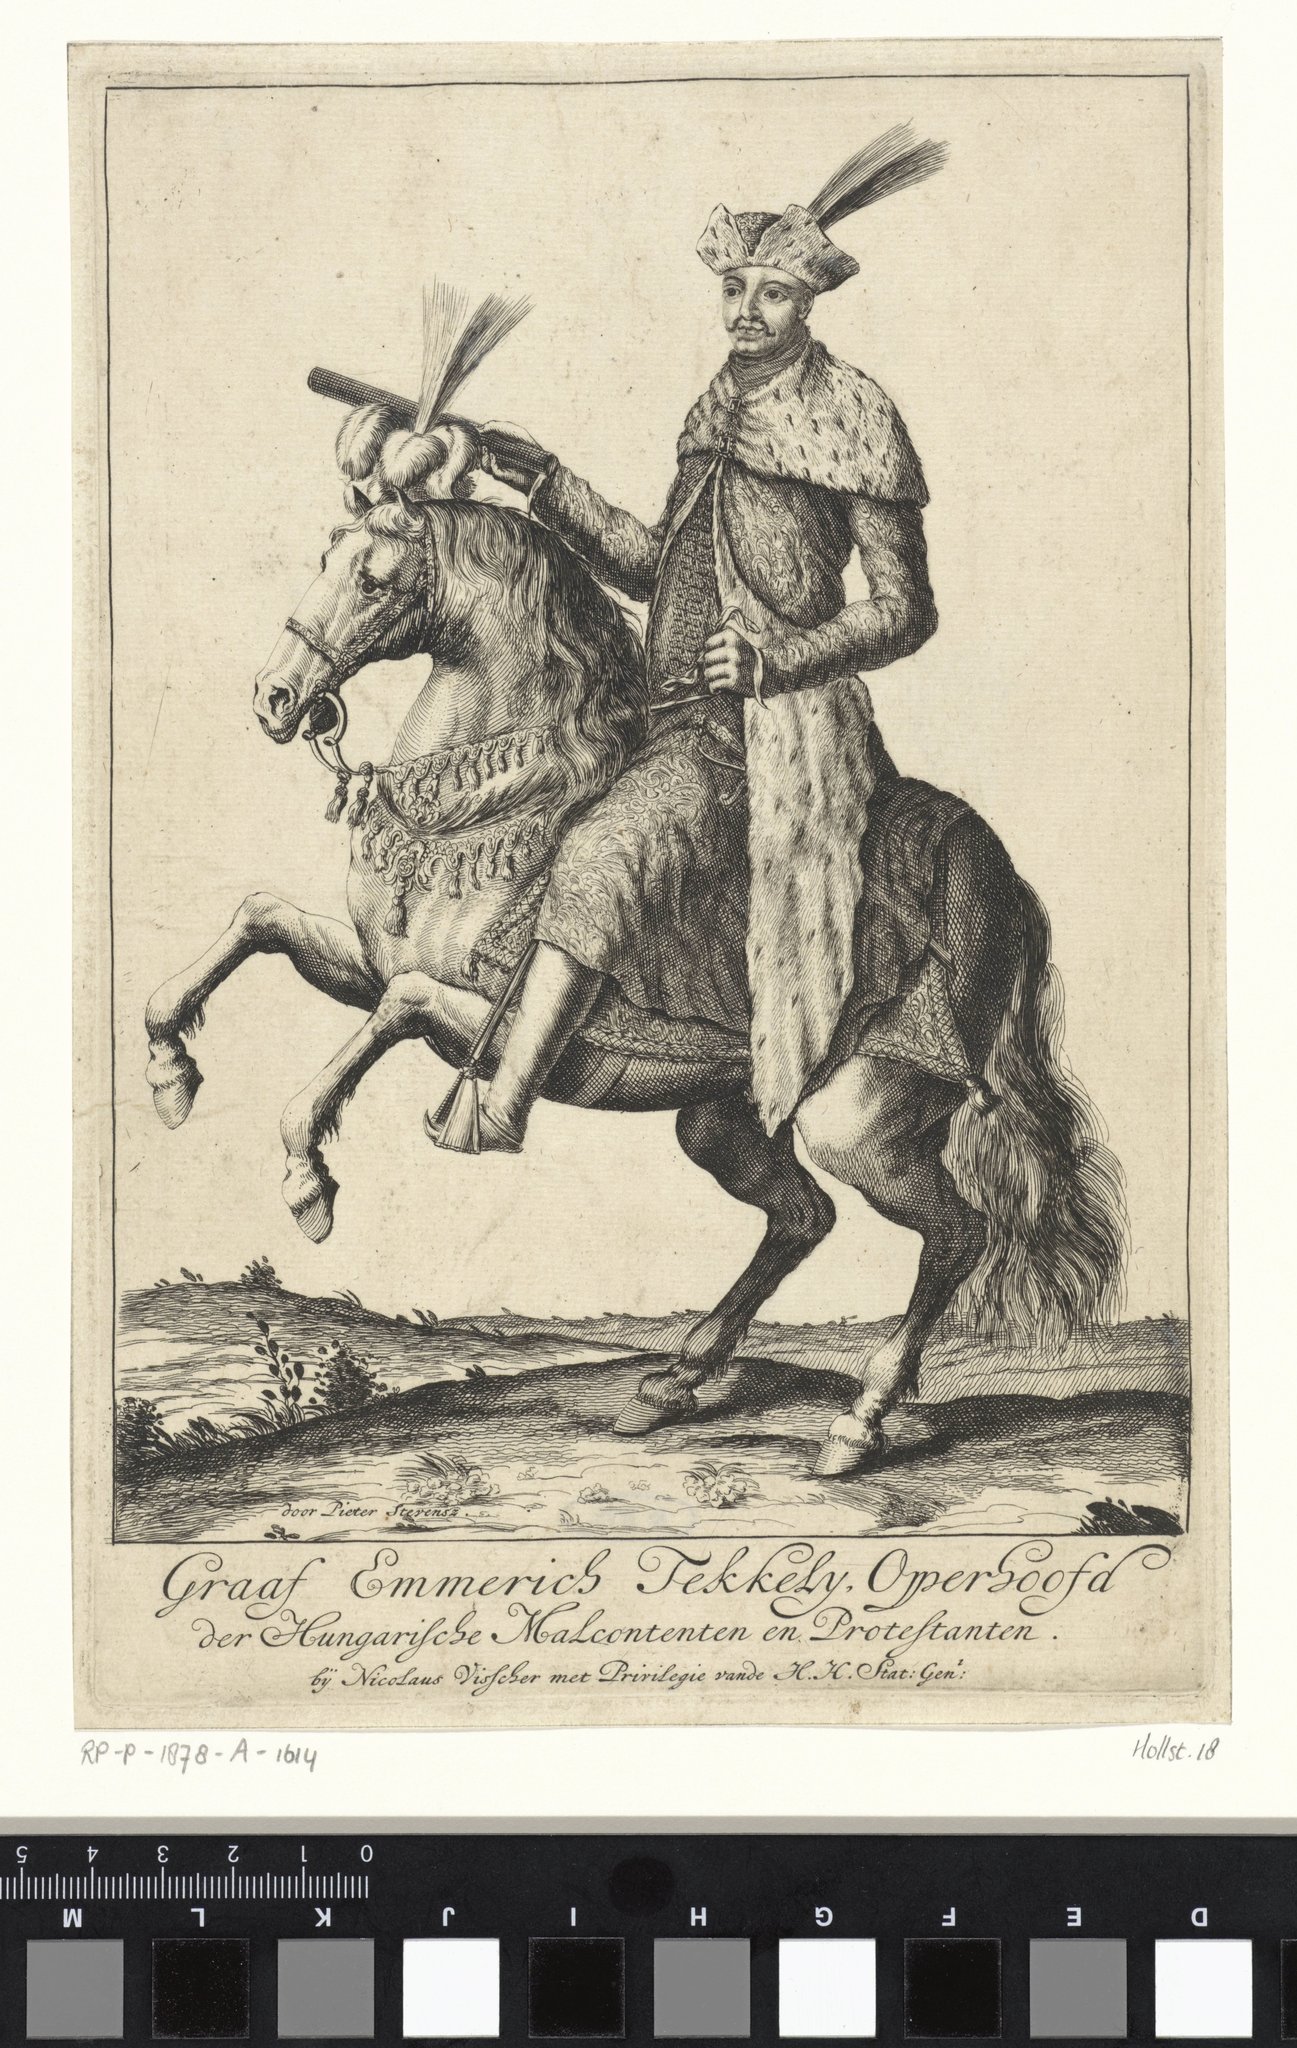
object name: print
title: Ruiterportret van Imre Thököly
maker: pieter stevens (vermeld in 1689)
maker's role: print maker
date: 1678-1702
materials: paper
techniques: engraving, etching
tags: equestrian state-portrait, baton of general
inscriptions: collector's mark: Lugt 2228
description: Portret van Hongaars staatsman Imre Thököly te paard met een commandostaf in zijn hand. Onderaan in de marge zijn naam en functie in het Nederlands.